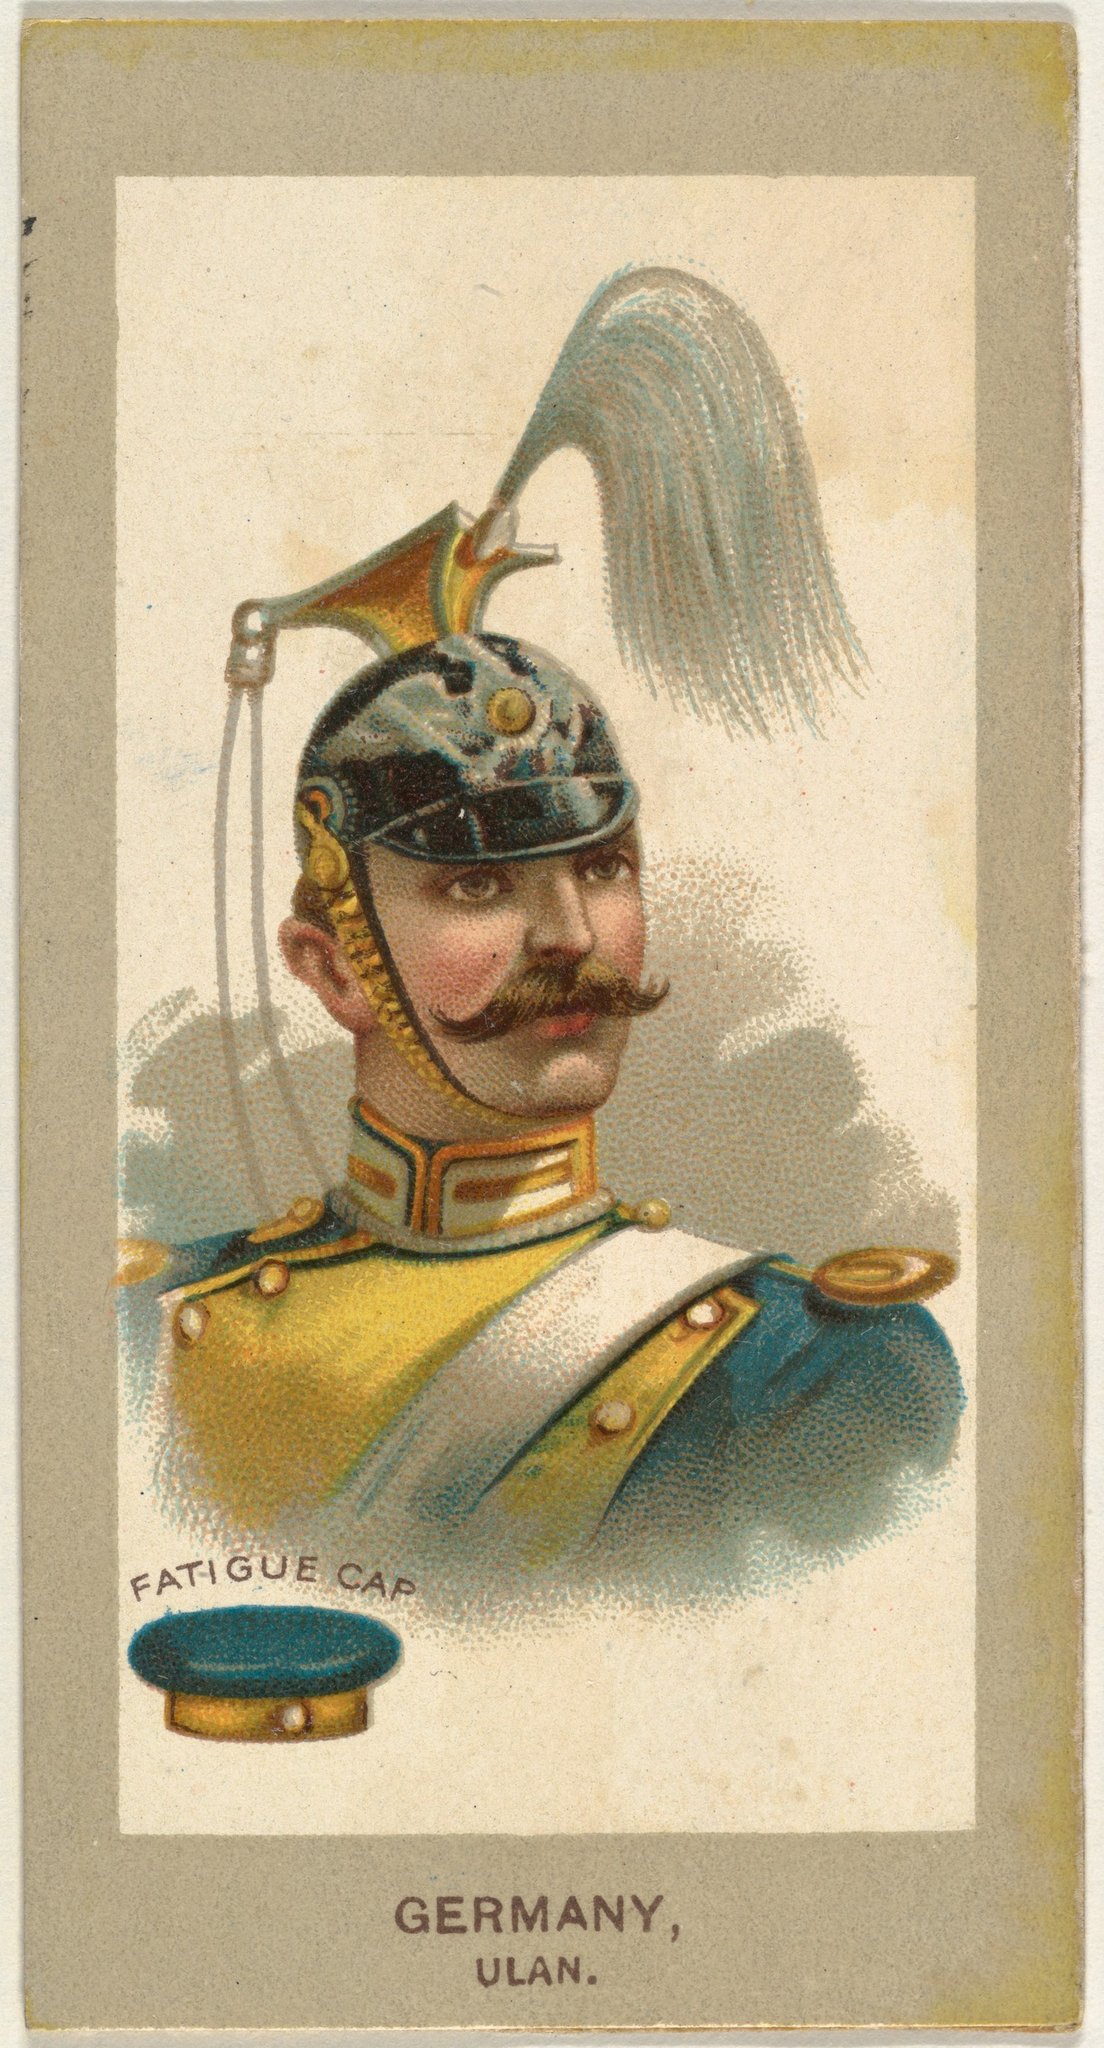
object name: print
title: Fatigue Cap, Ulan, Germany, from the Military Uniforms series (T182) issued by Abdul Cigarettes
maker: abdul cigarettes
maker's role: publisher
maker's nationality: american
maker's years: 1881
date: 1881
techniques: color lithograph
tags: uniforms,military,men